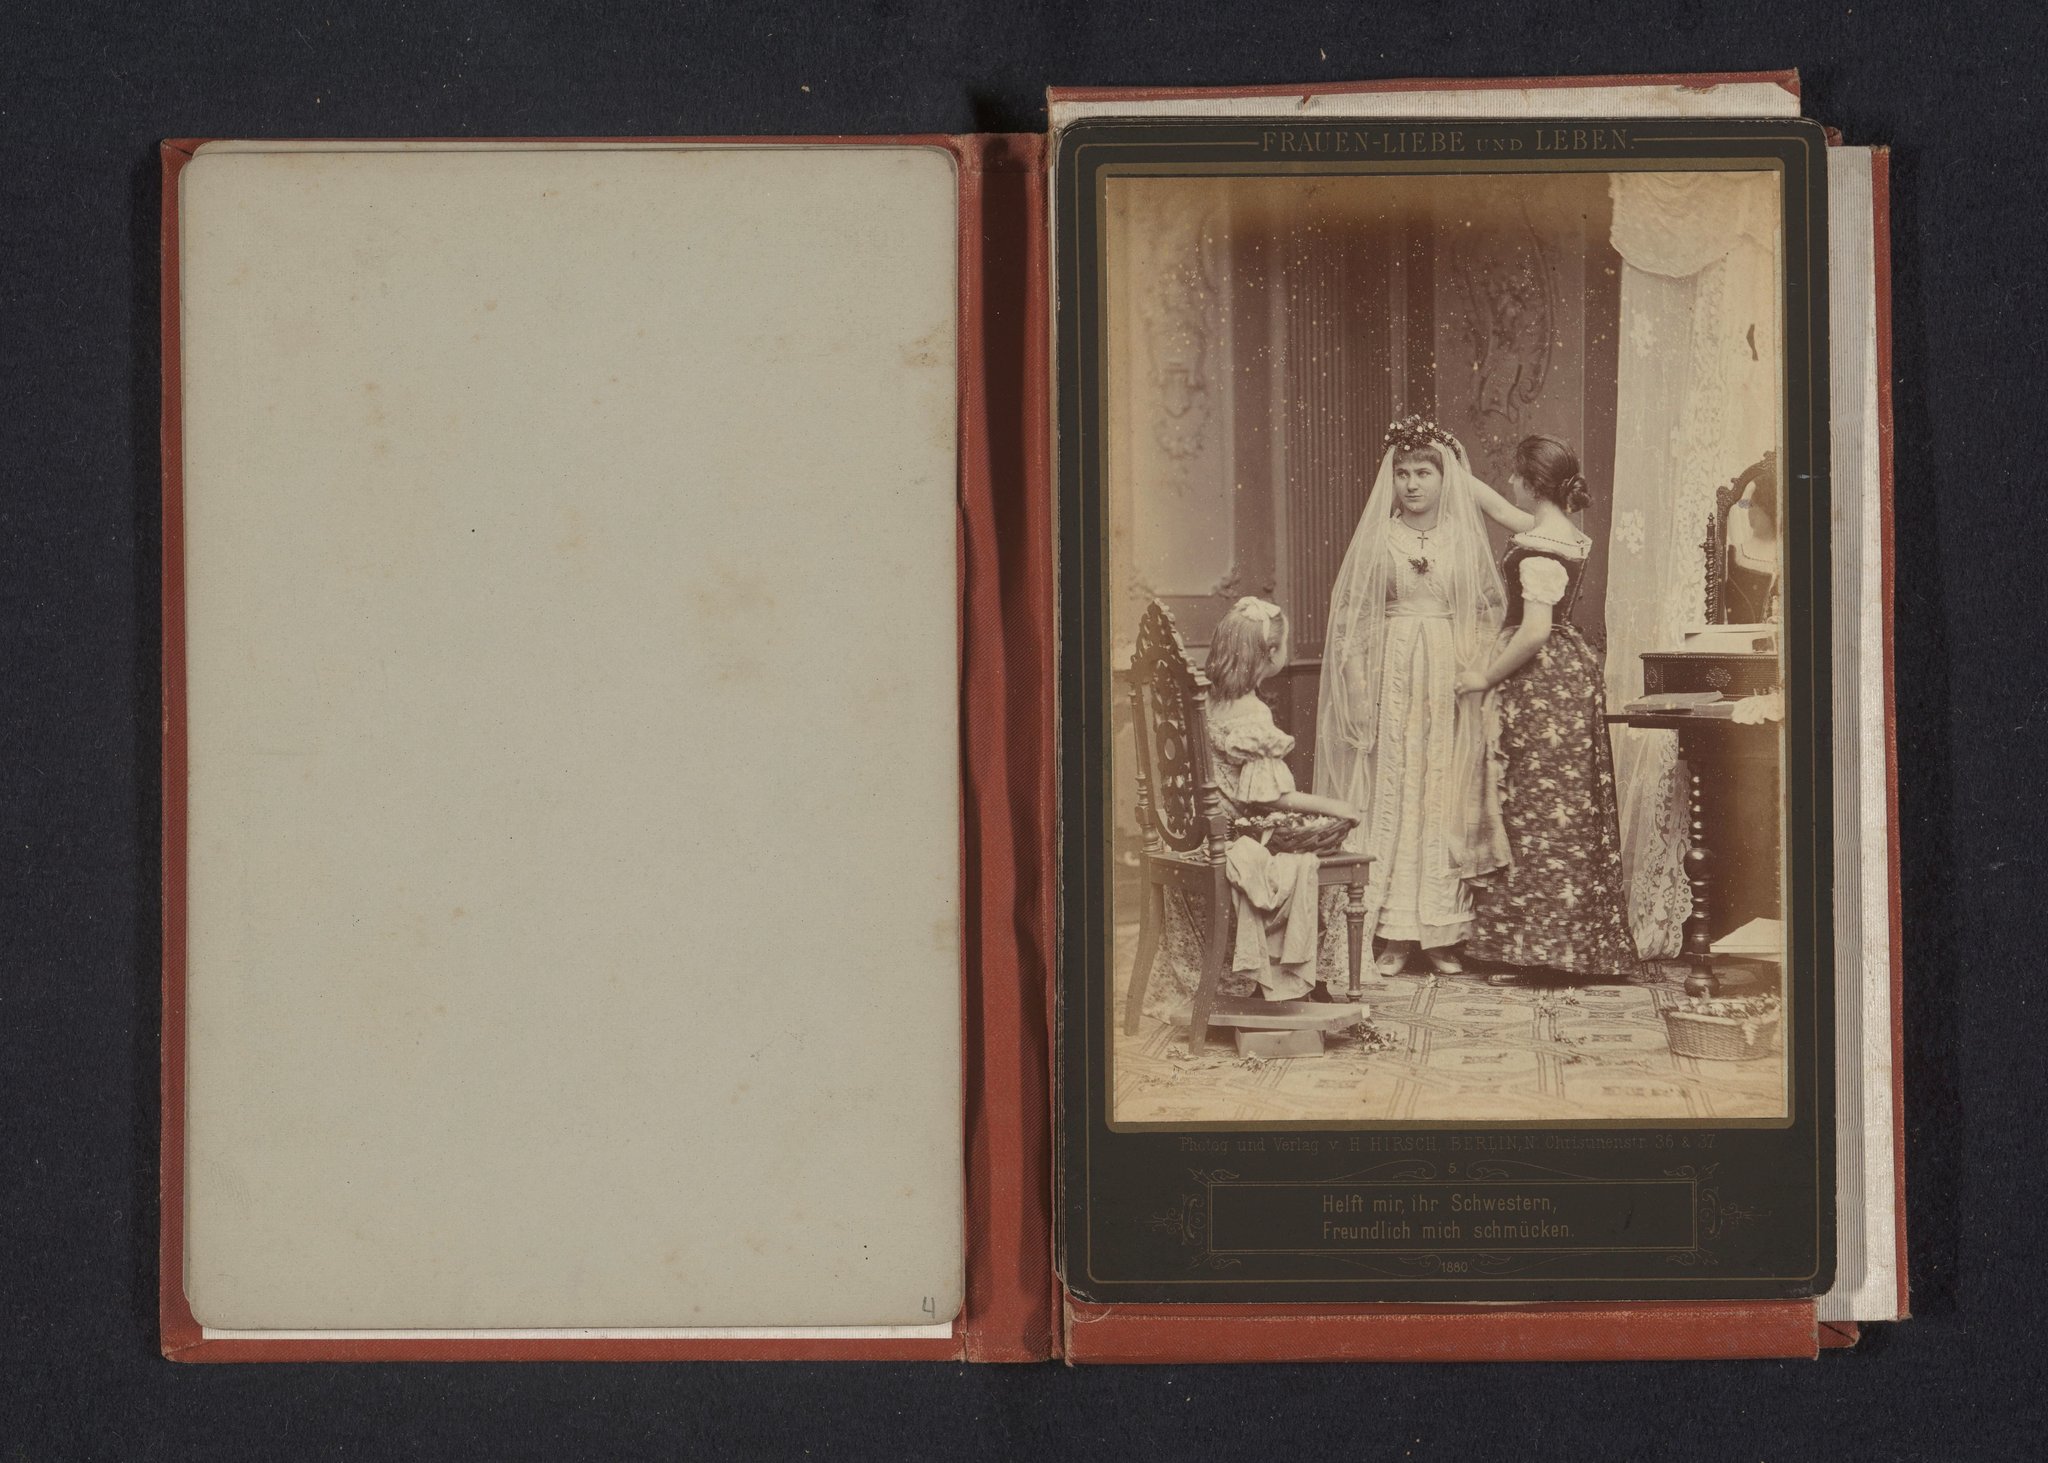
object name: page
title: Frauen-Liebe und Leben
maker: hugo hirsch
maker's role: publisher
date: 1880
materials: photographic support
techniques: albumen print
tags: adult woman, dressing the bride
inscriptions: number: ‘5.’, name: ‘Photog. und Verlag v. H. Hirsch, Berlin, N Christinenstr. 36 & 37’